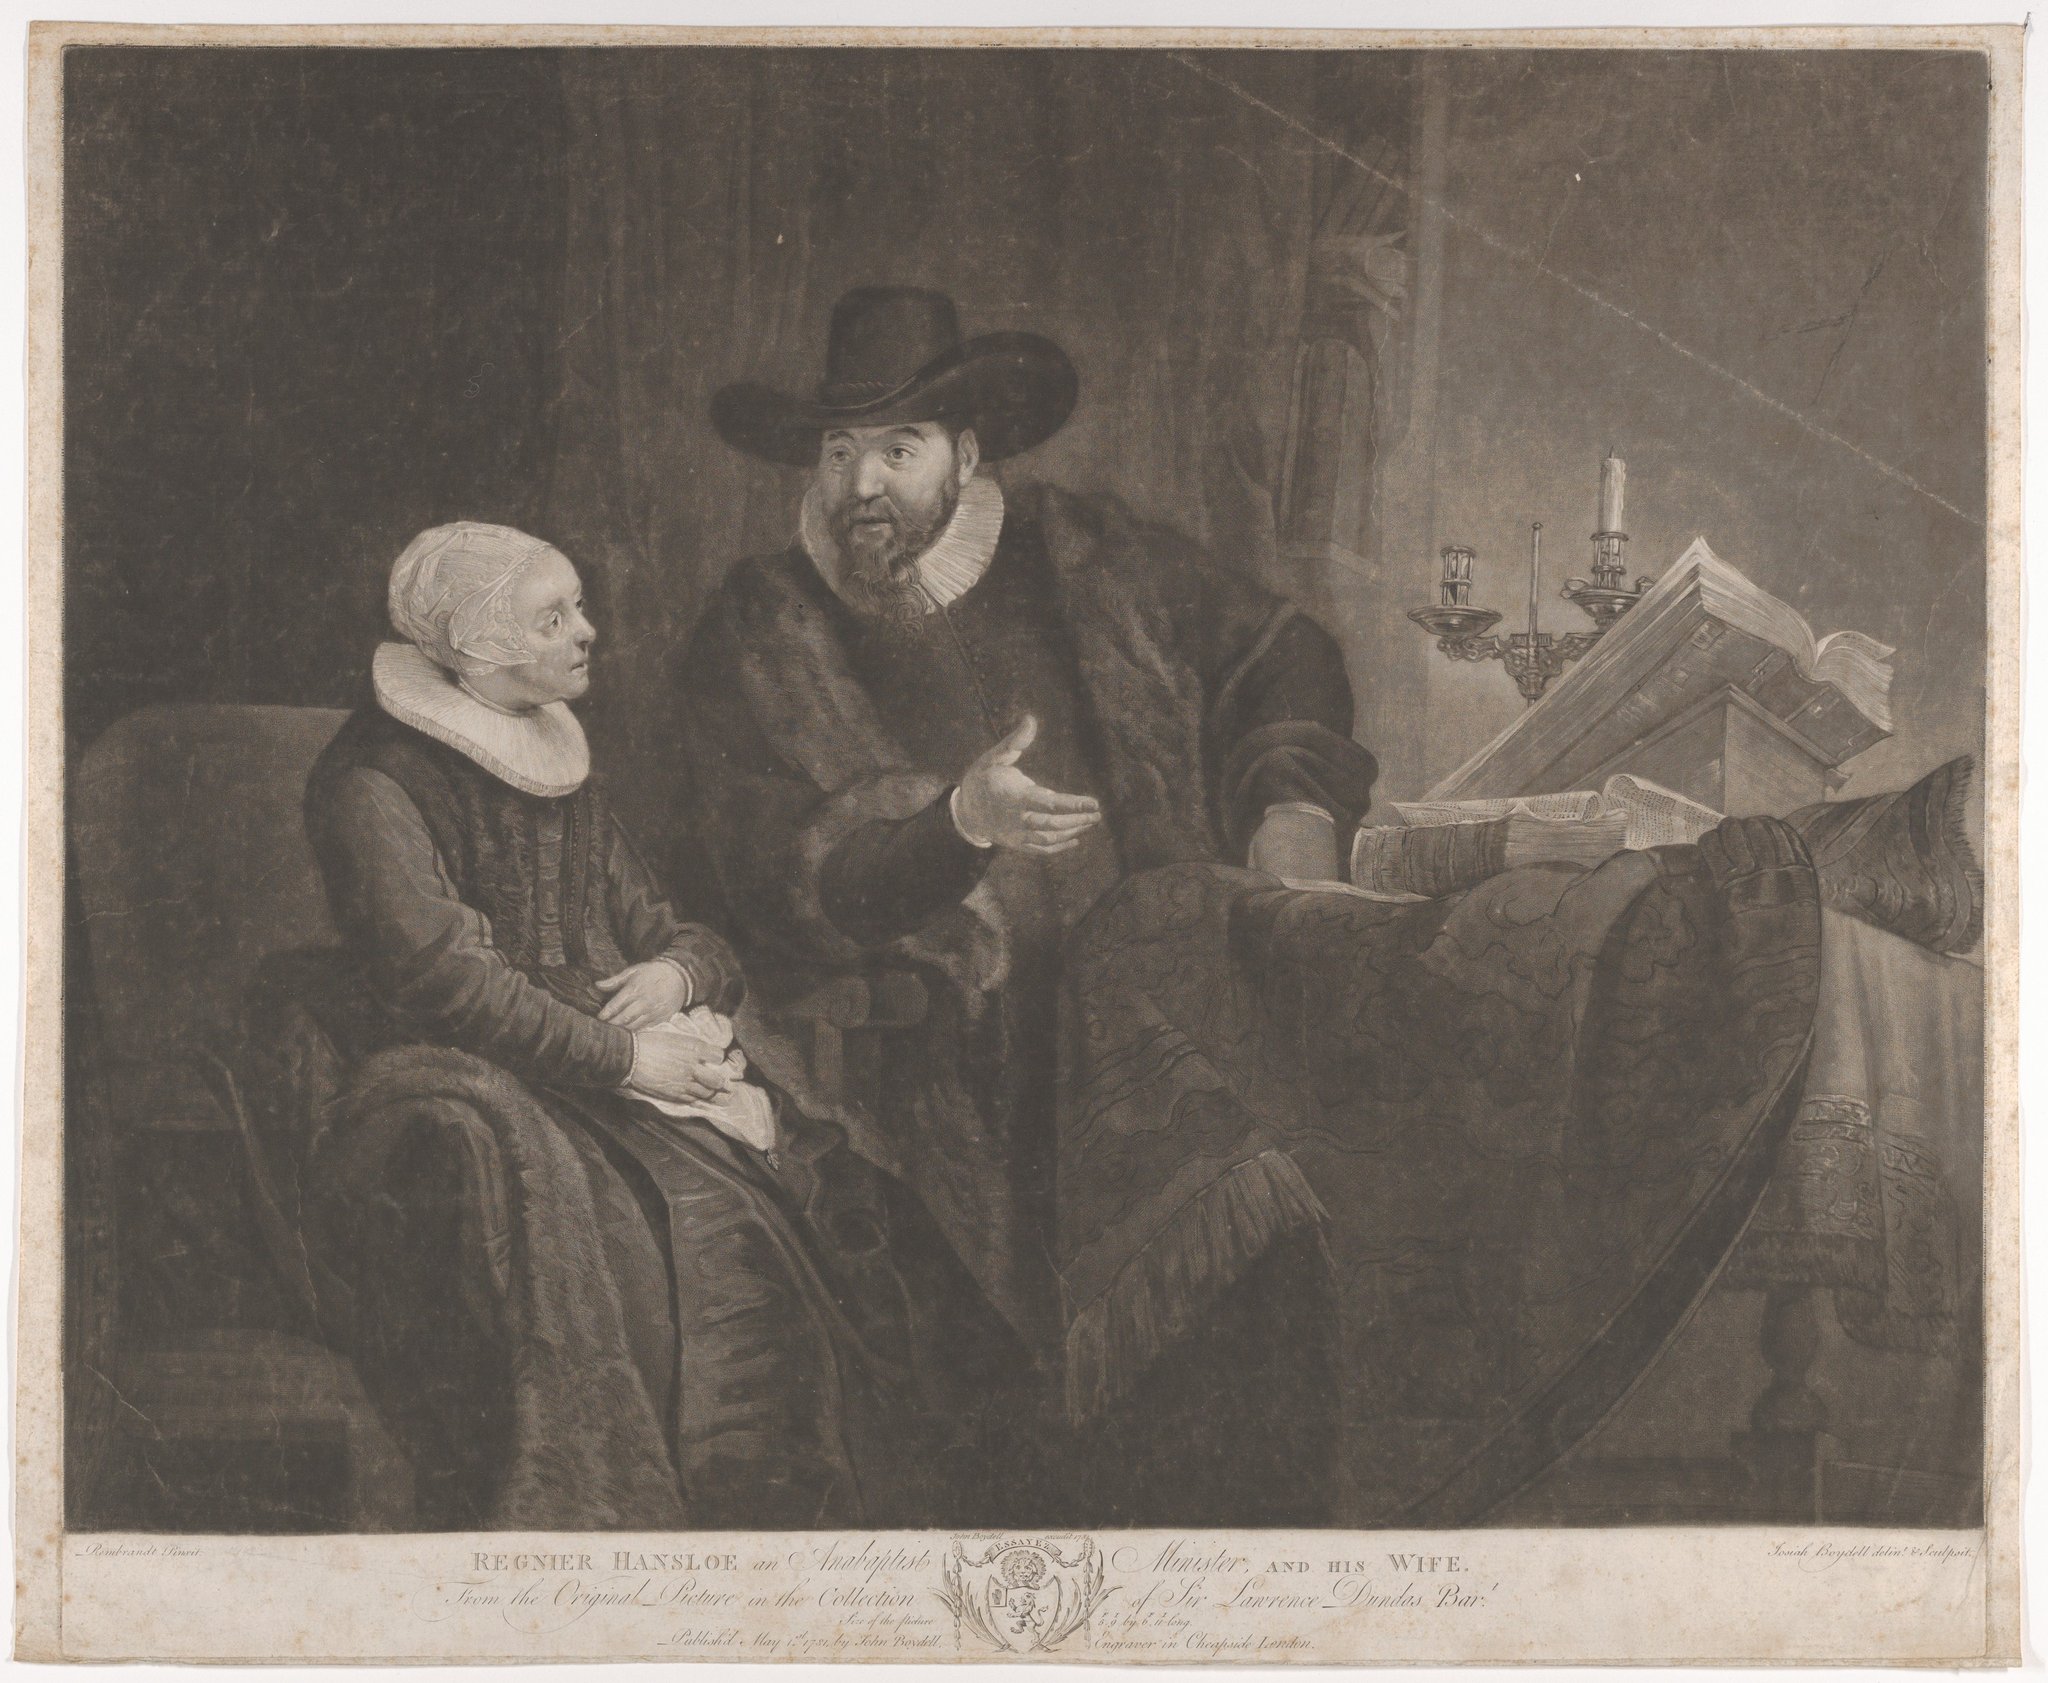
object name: print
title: Regnier Hansloe, an Anabaptist Minister, and His Wife (Cornelis Claesz Anslo and His Wife Aeltje Gerritsdr Schouten)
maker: josiah boydell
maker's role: engraver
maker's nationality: british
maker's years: 1752-1817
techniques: etching, mezzotint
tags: men,women